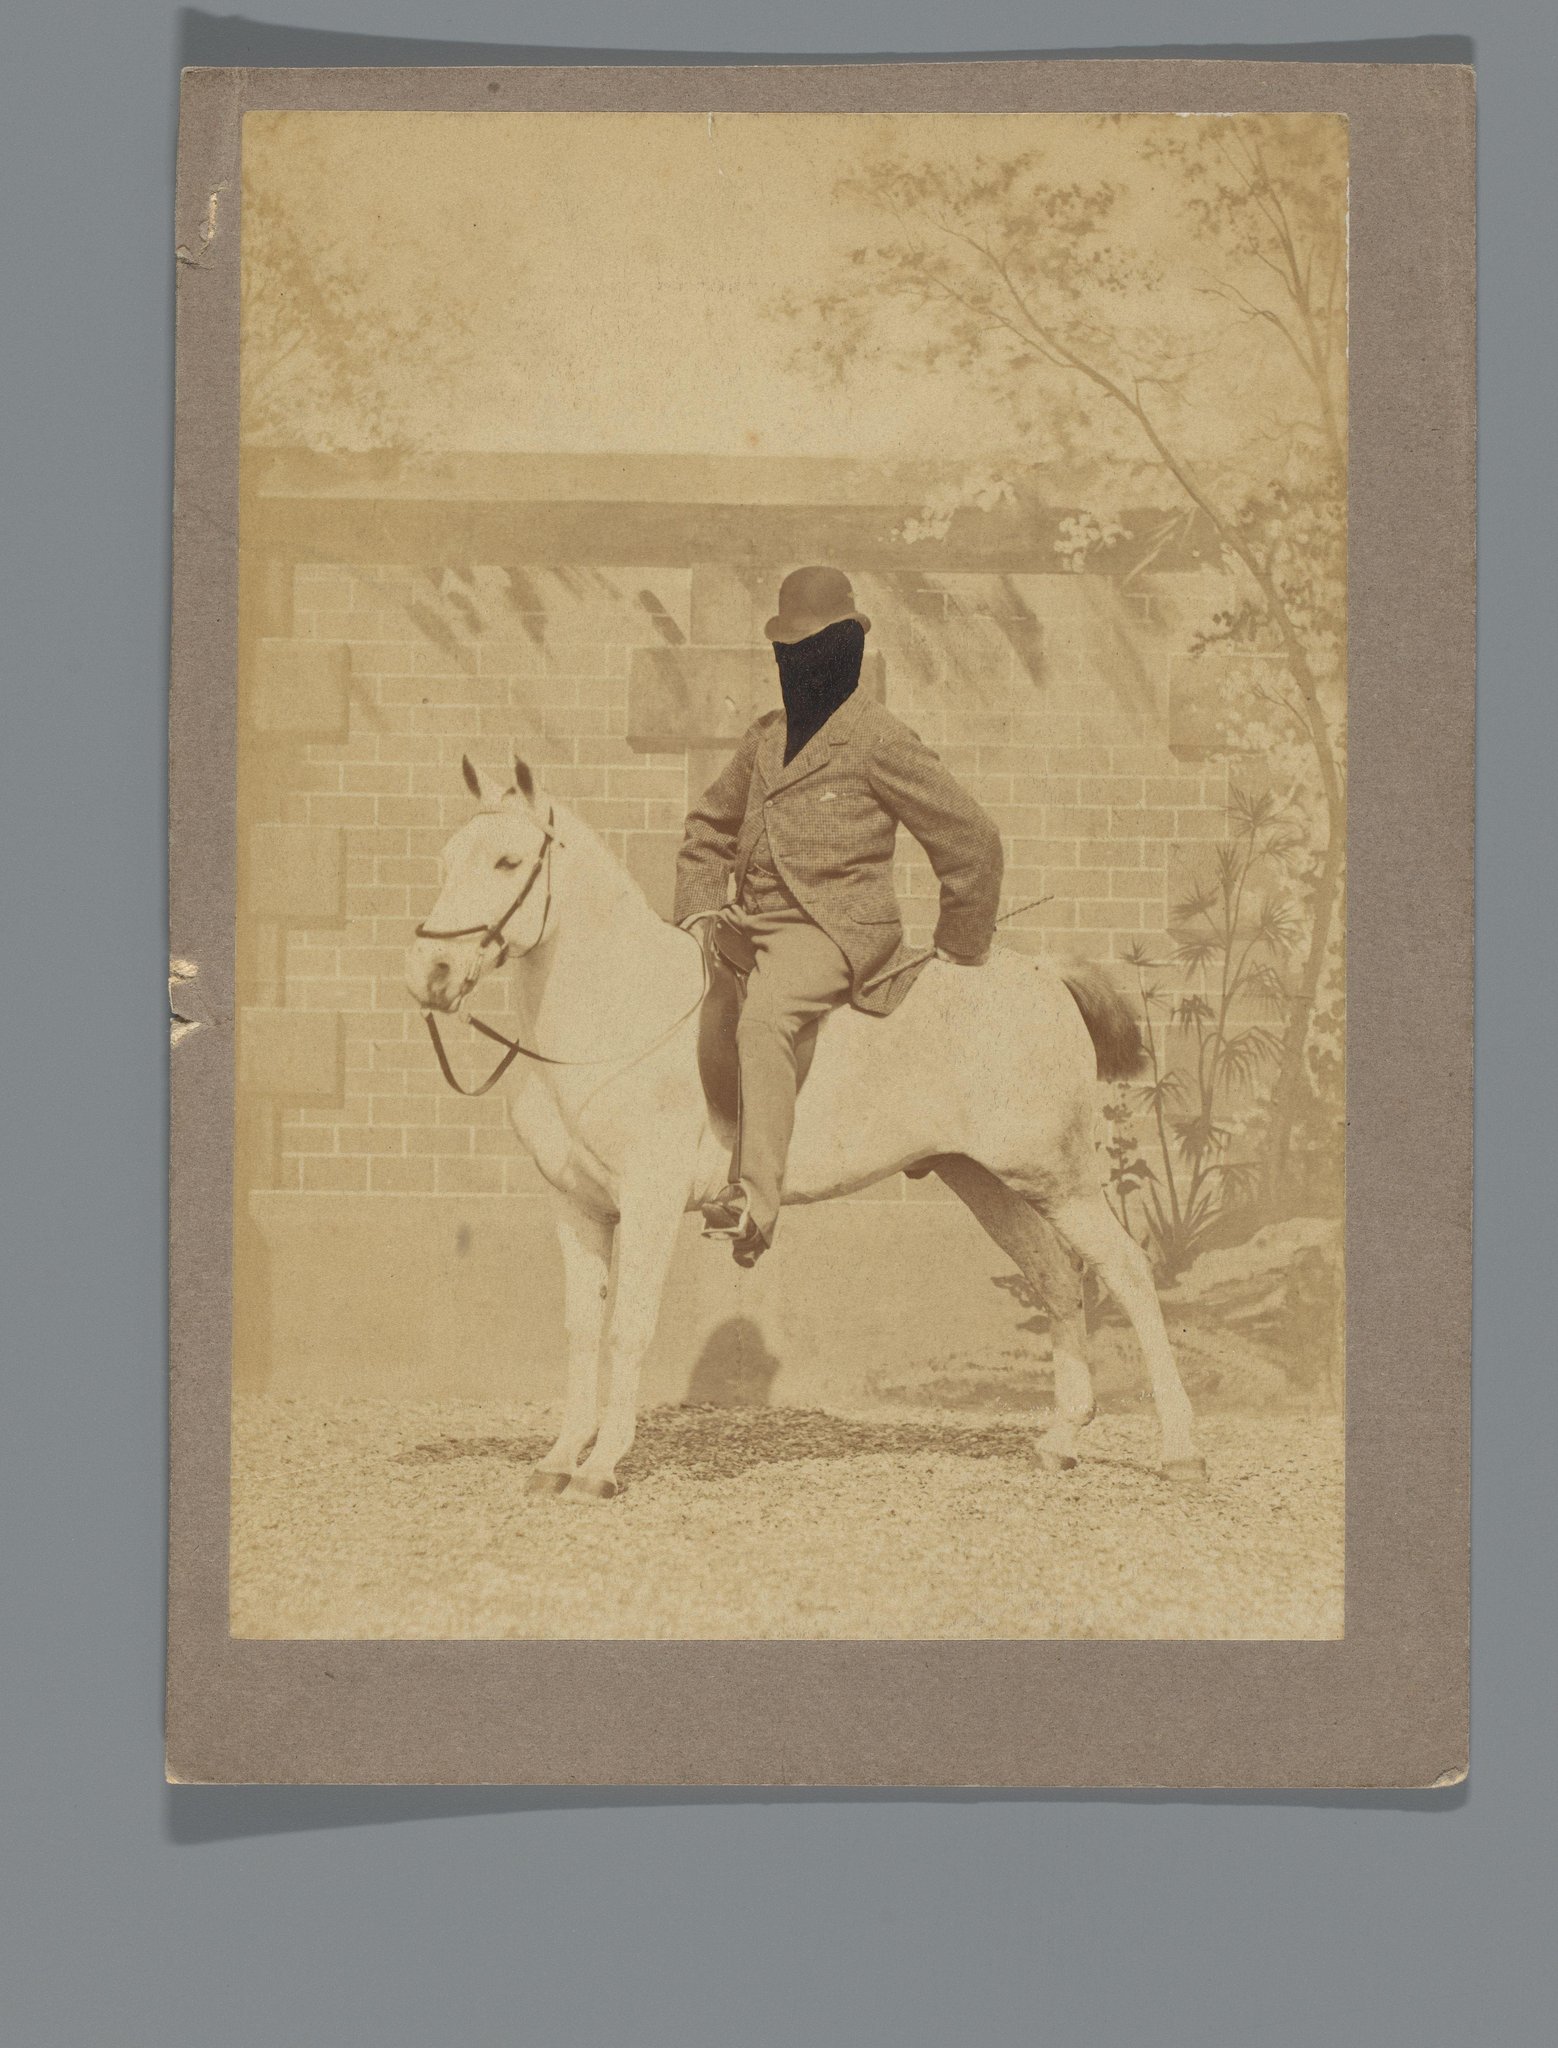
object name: photograph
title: Man te paard waarvan het gezicht is weggeretoucheerd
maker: Anonymous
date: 1880-1910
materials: cardboard, photographic support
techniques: albumen print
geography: united states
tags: united states of america